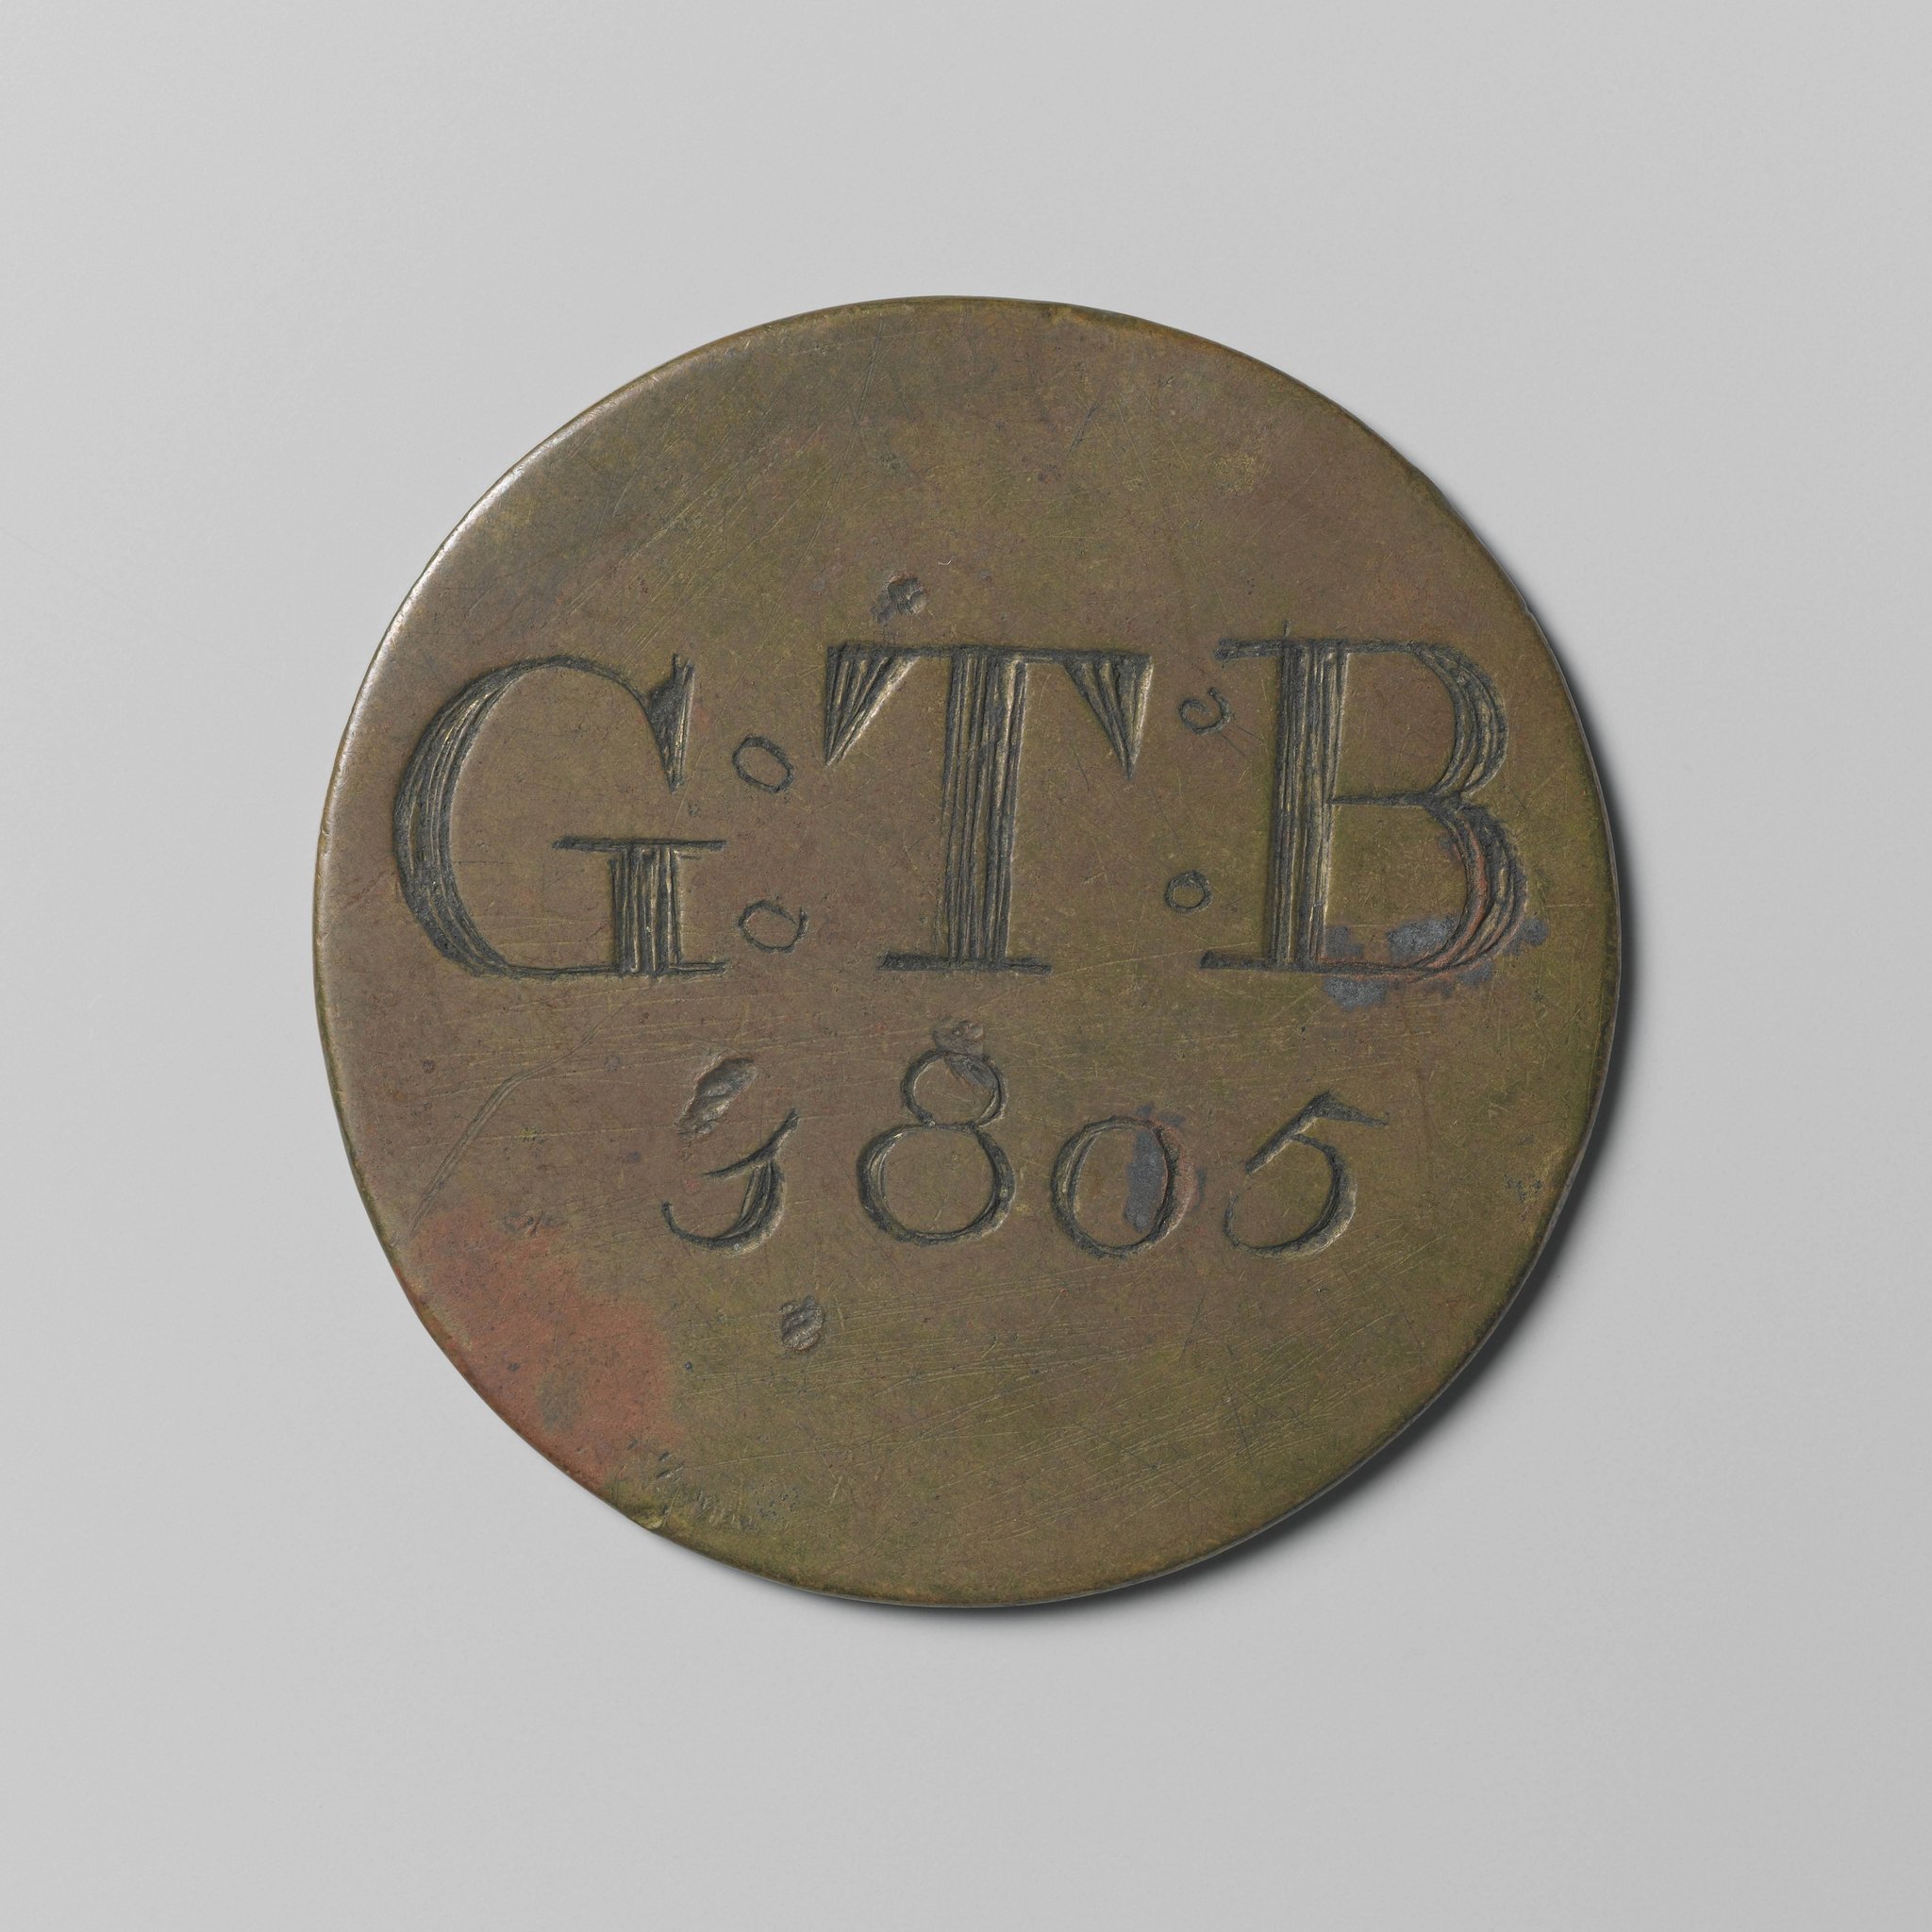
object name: insignia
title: Visverkopersgilde van Amsterdam, gildepenning van P. van Son, commissaris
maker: Anonymous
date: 1805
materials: brass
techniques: engraving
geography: amsterdam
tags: amsterdam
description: Messing penning. Voorzijde: opschrift. Keerzijde: opschrift.